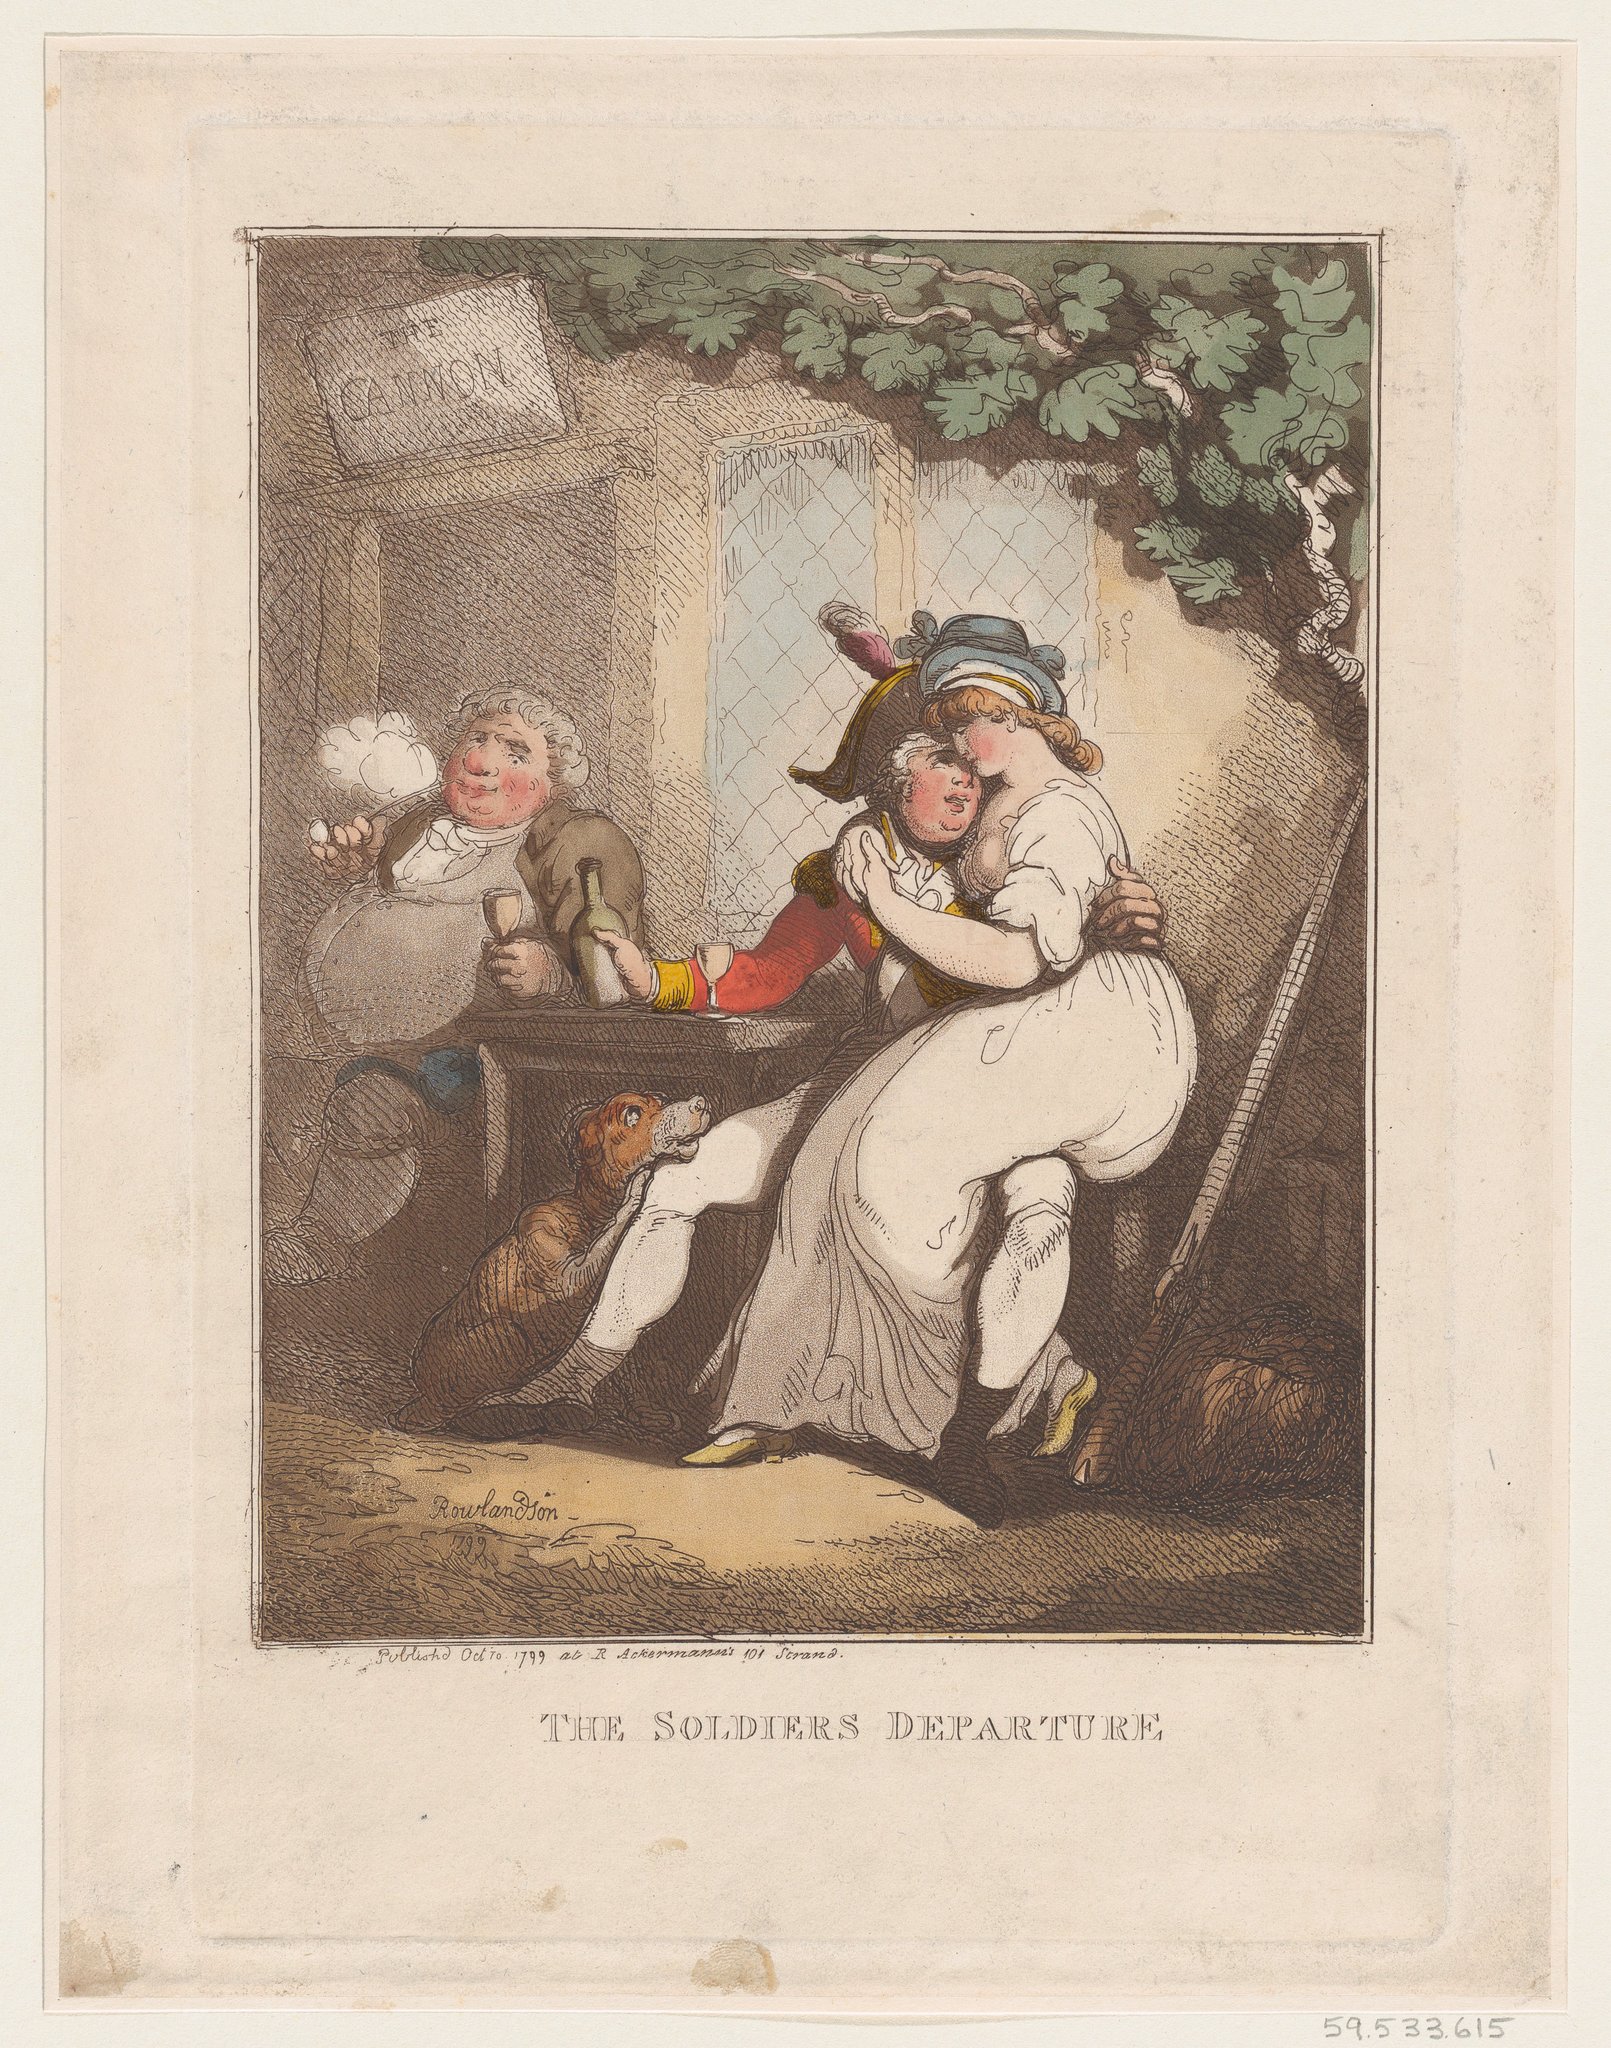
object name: print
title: The Soldier's Departure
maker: thomas rowlandson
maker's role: artist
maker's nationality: british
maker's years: 1757-1827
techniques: etching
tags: men,women,dogs